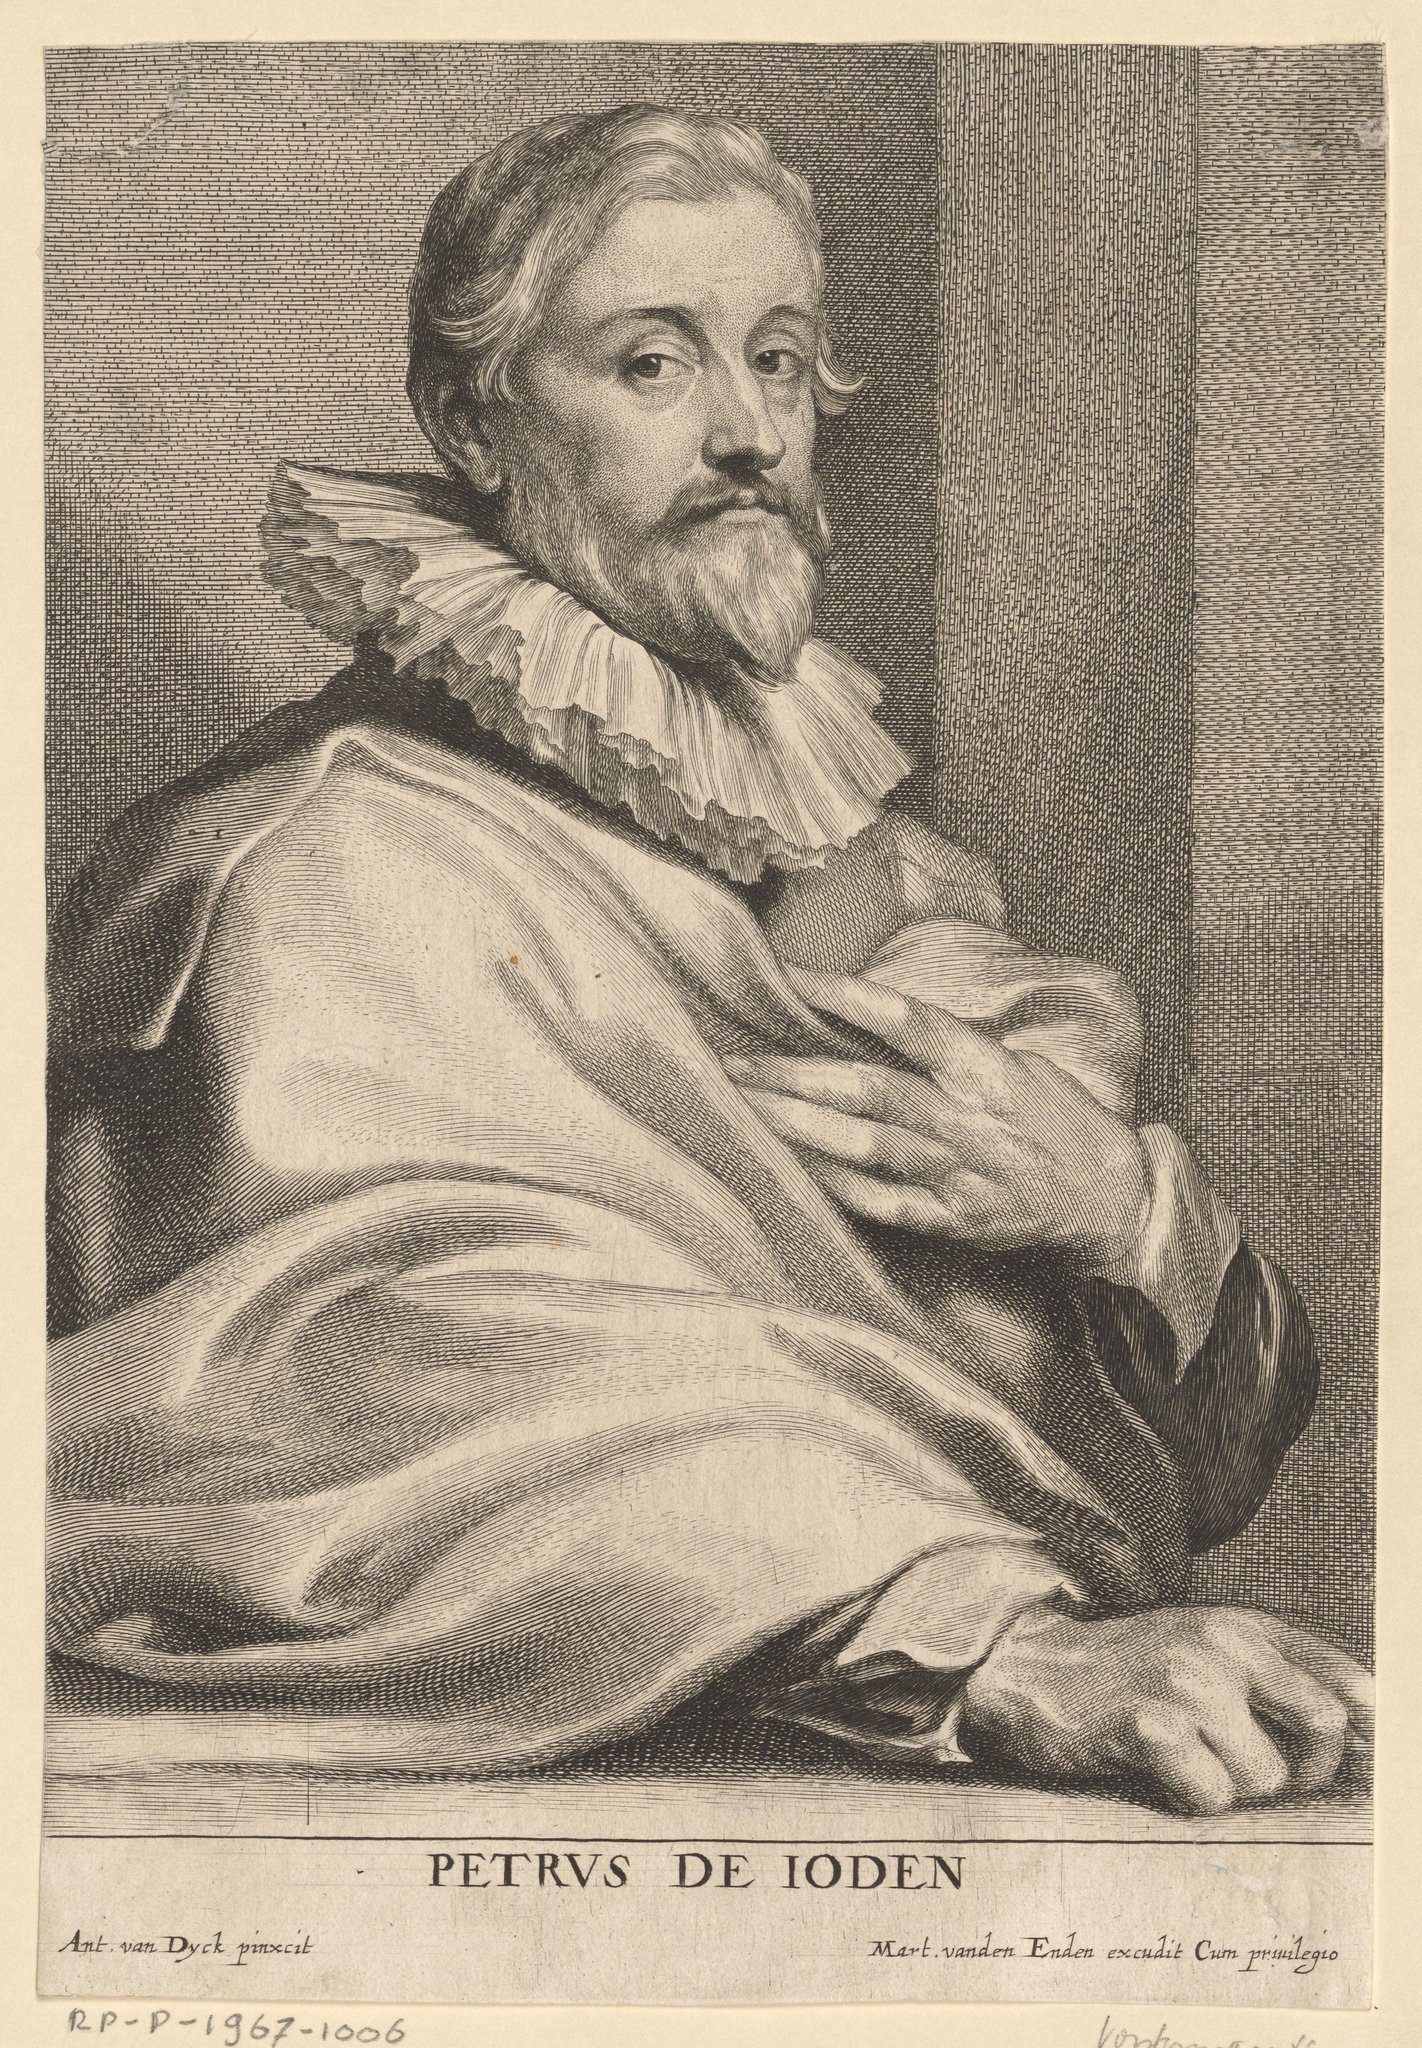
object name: print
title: Portret van Pieter de Jode I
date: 1645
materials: paper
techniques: engraving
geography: antwerp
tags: print maker, historical persons, portrait, self-portrait of graphic artist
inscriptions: collector's mark: Lugt 2228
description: Prent ook gebruikt voor: Icones principum, virorum doctorum, pictorum, chalcographorum, statuariorum nec non amatorum pictoriae artis numero centum ab Ant. van Dyck ad vivum expressae ejusque sumptibus aeri incisae. Antwerpen: Gillis Hendricx, [1645].